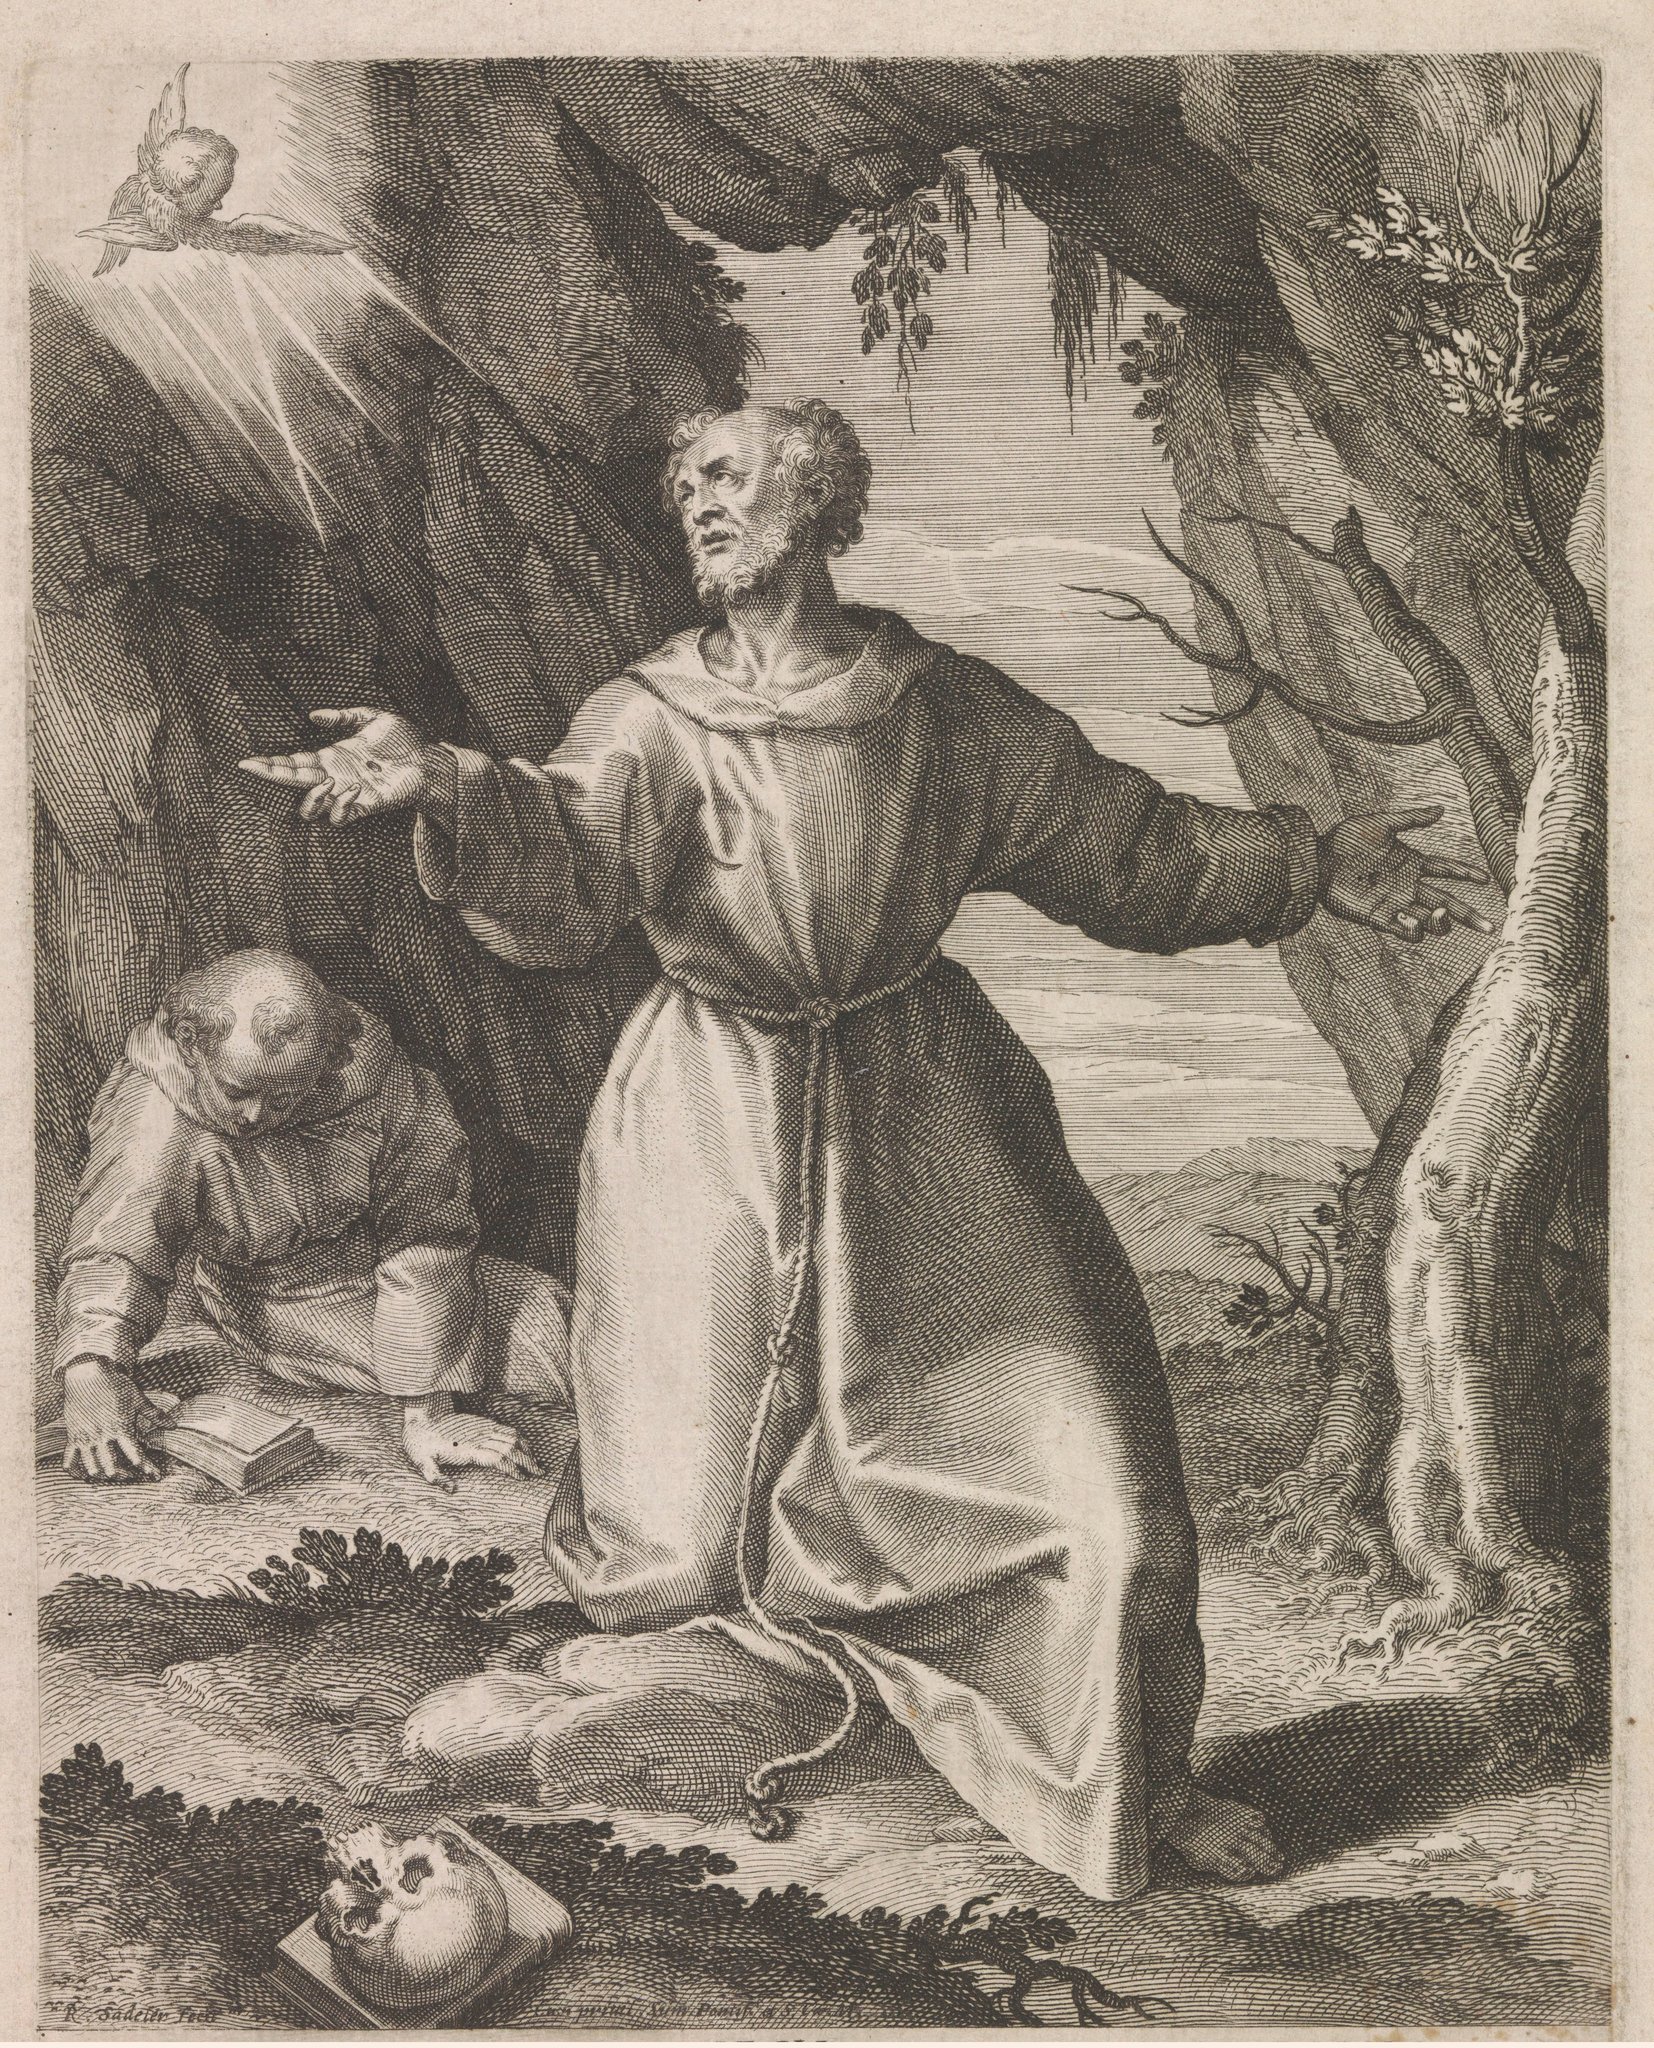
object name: print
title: Franciscus van Assisi ontvangt de stigmata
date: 1599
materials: paper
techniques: engraving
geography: venice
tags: stigmatization of st. francis of assisi: in retreat on mount alverna, he beholds a vision of christ on the cross enveloped by wings (like a seraph with six wings); rays passing down to the body of the kneeling saint form the marks of the five wounds of christ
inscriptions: collector's mark: Lugt 240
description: De H. Franciscus zit geknield in de wildernis. Hij krijgt een visioen van een engel met zes vleugel en ontvangt zijn stigmata. Op de achtergrond zit een andere monnik. Op de voorgrond een schedel.